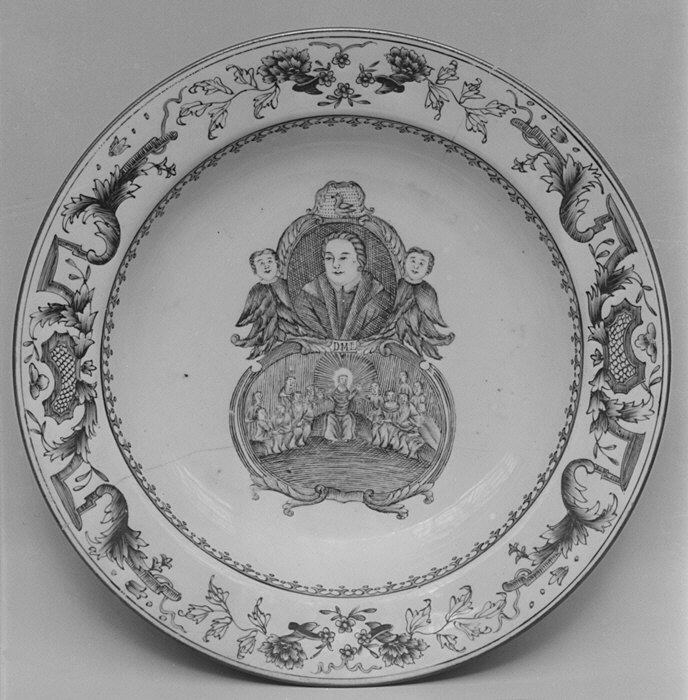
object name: dish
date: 1750-1760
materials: hard paste porcelain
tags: faces,men,portraits